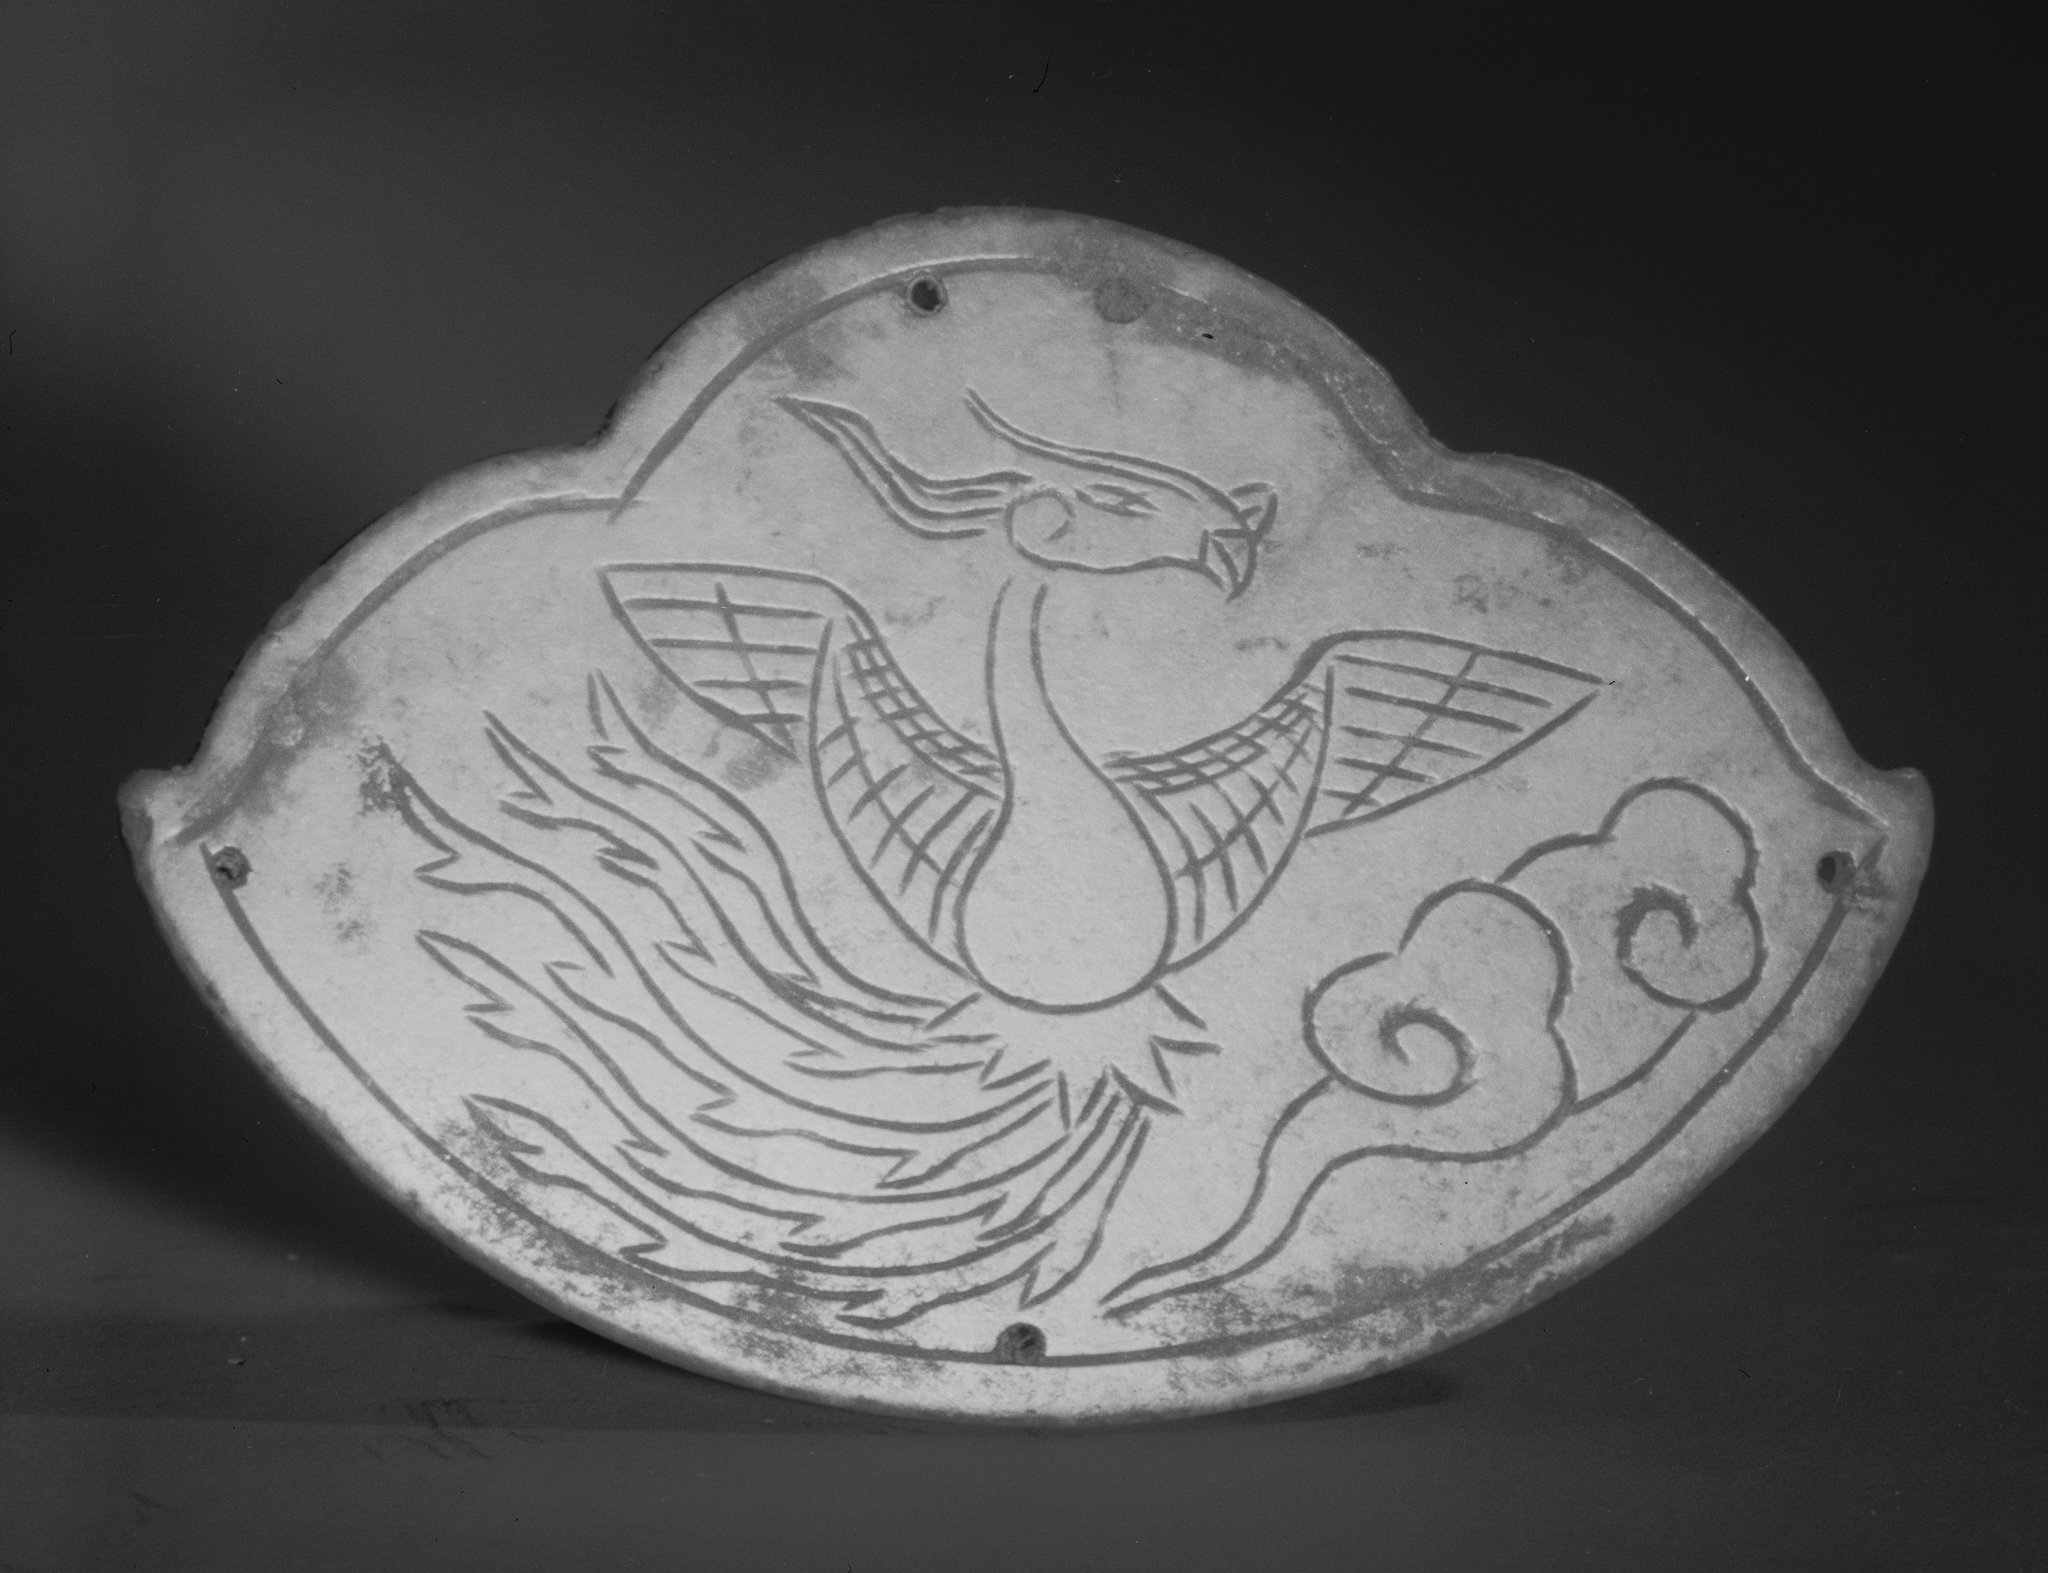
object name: pendant plaque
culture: chinese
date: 1101-1300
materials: jade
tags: birds